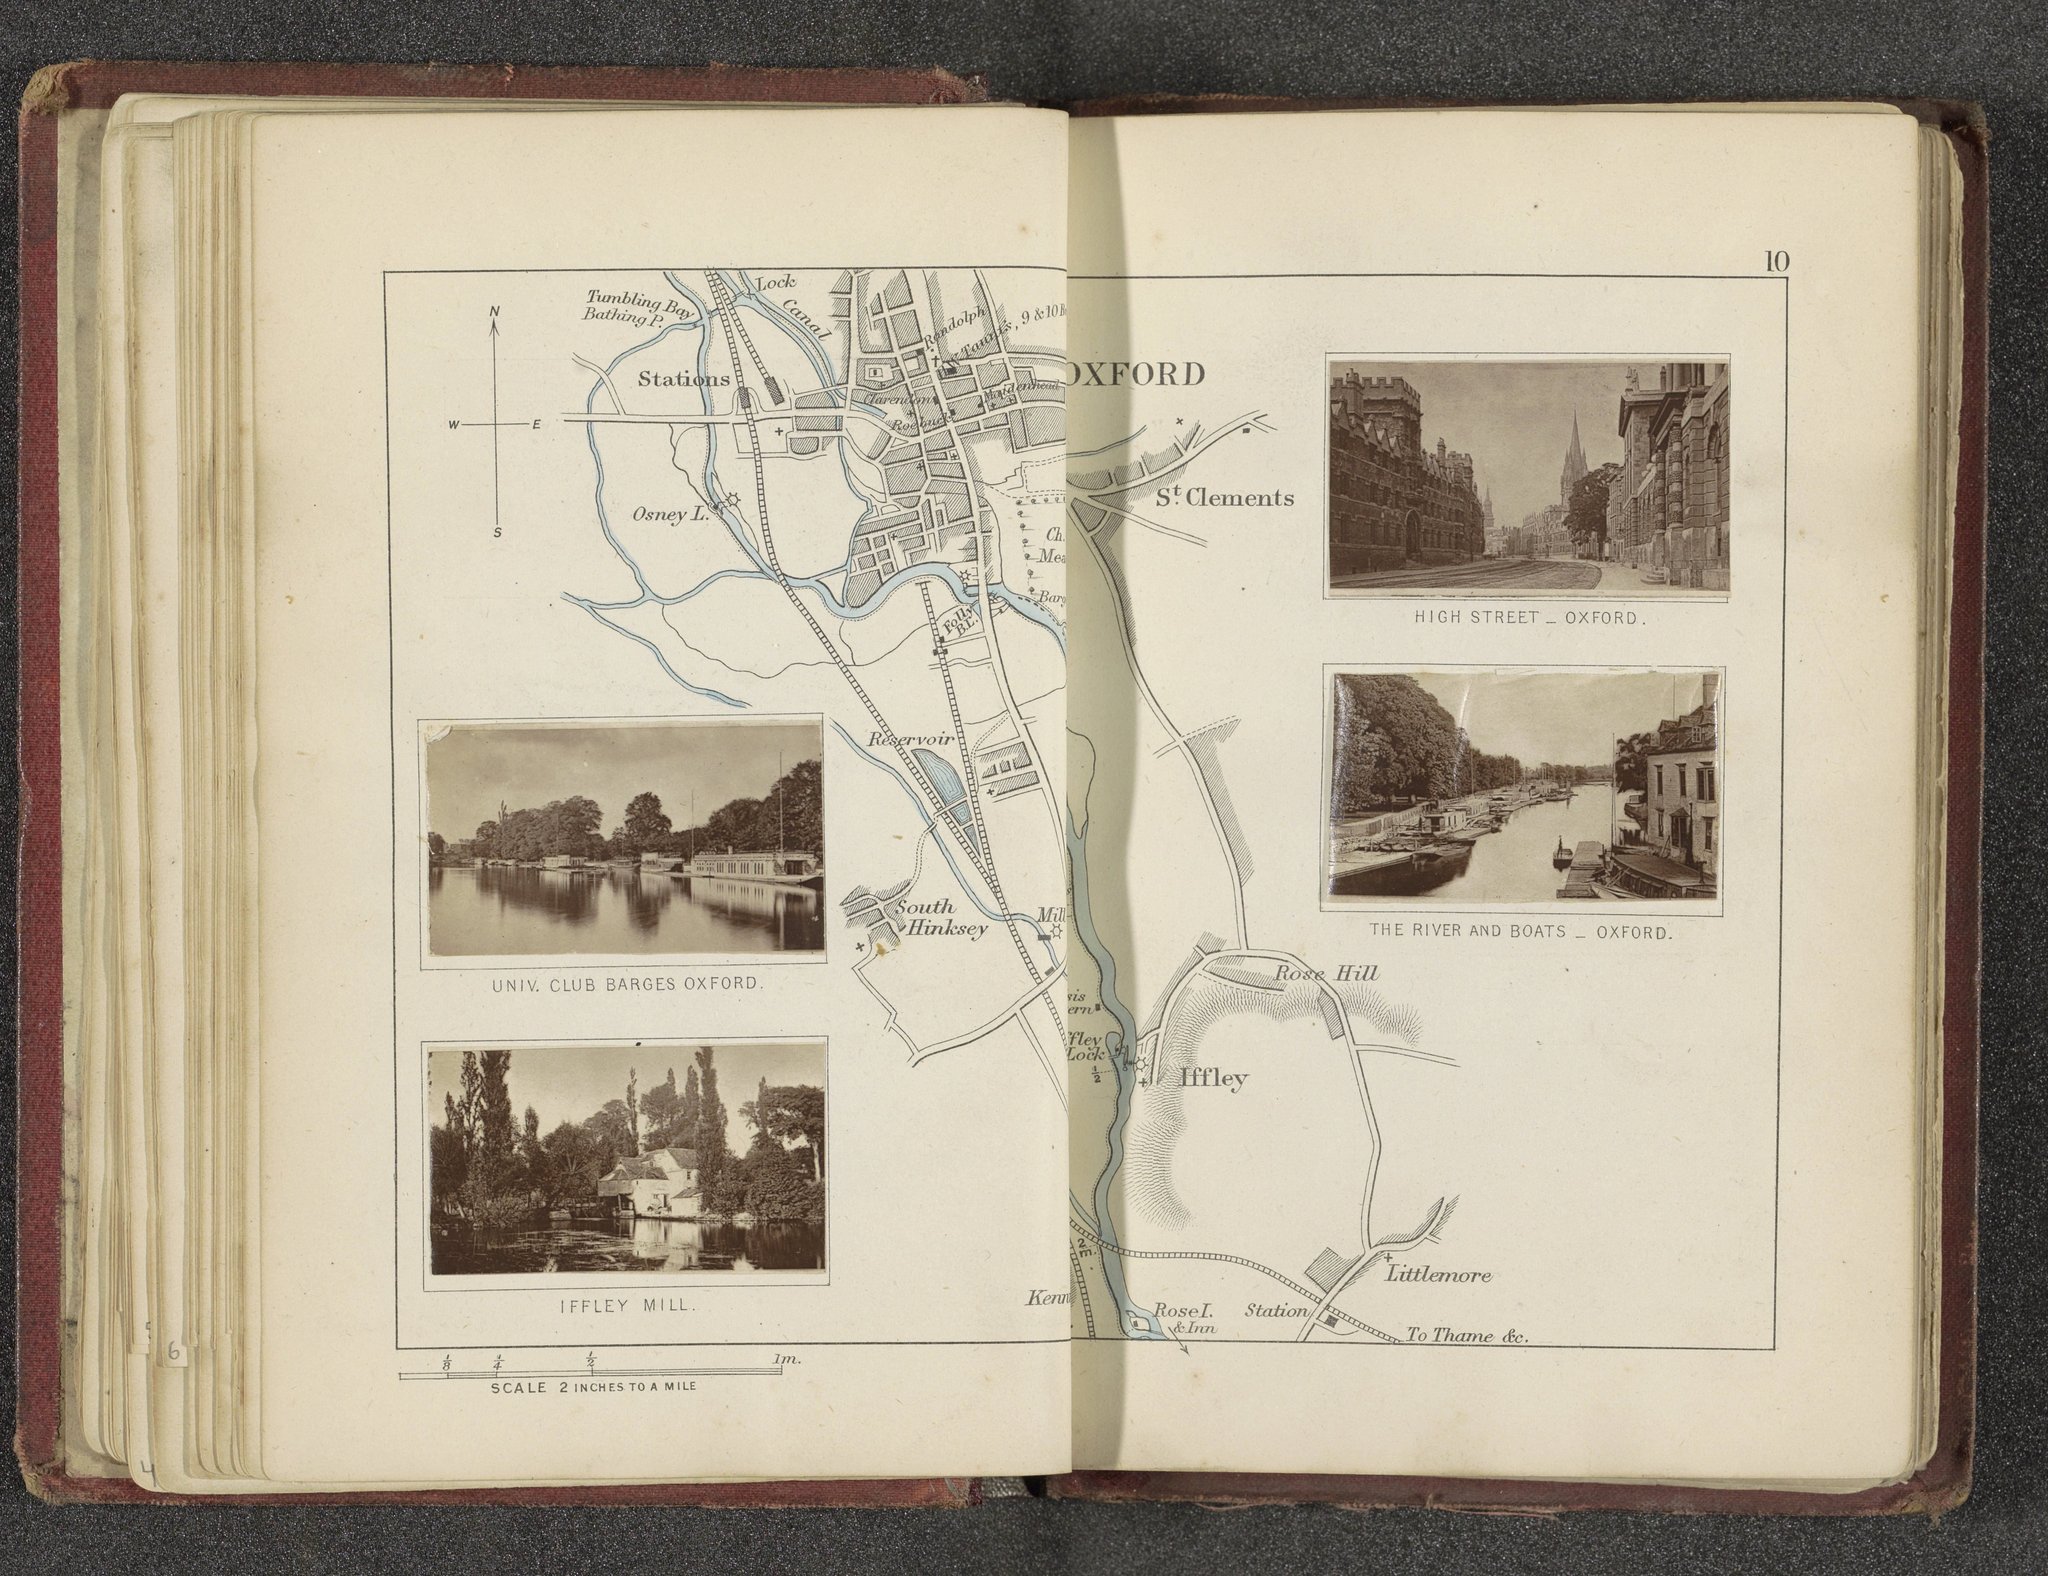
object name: page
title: Kaart met vier afbeeldingen van plaatsen langs de Theems in de buurt van Oxford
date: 1878-1879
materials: paper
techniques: engraving, woodburytype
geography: oxford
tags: river, watermill in landscape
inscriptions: number: ‘10’, inscription: ‘Univ. club barges Oxford Iffley mill High street _ Oxford The river and boats _ Oxford’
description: Links: aanlegplaats voor binnenschepen en een molen bij Iffley, rechts: High street en de Theems in Oxford.